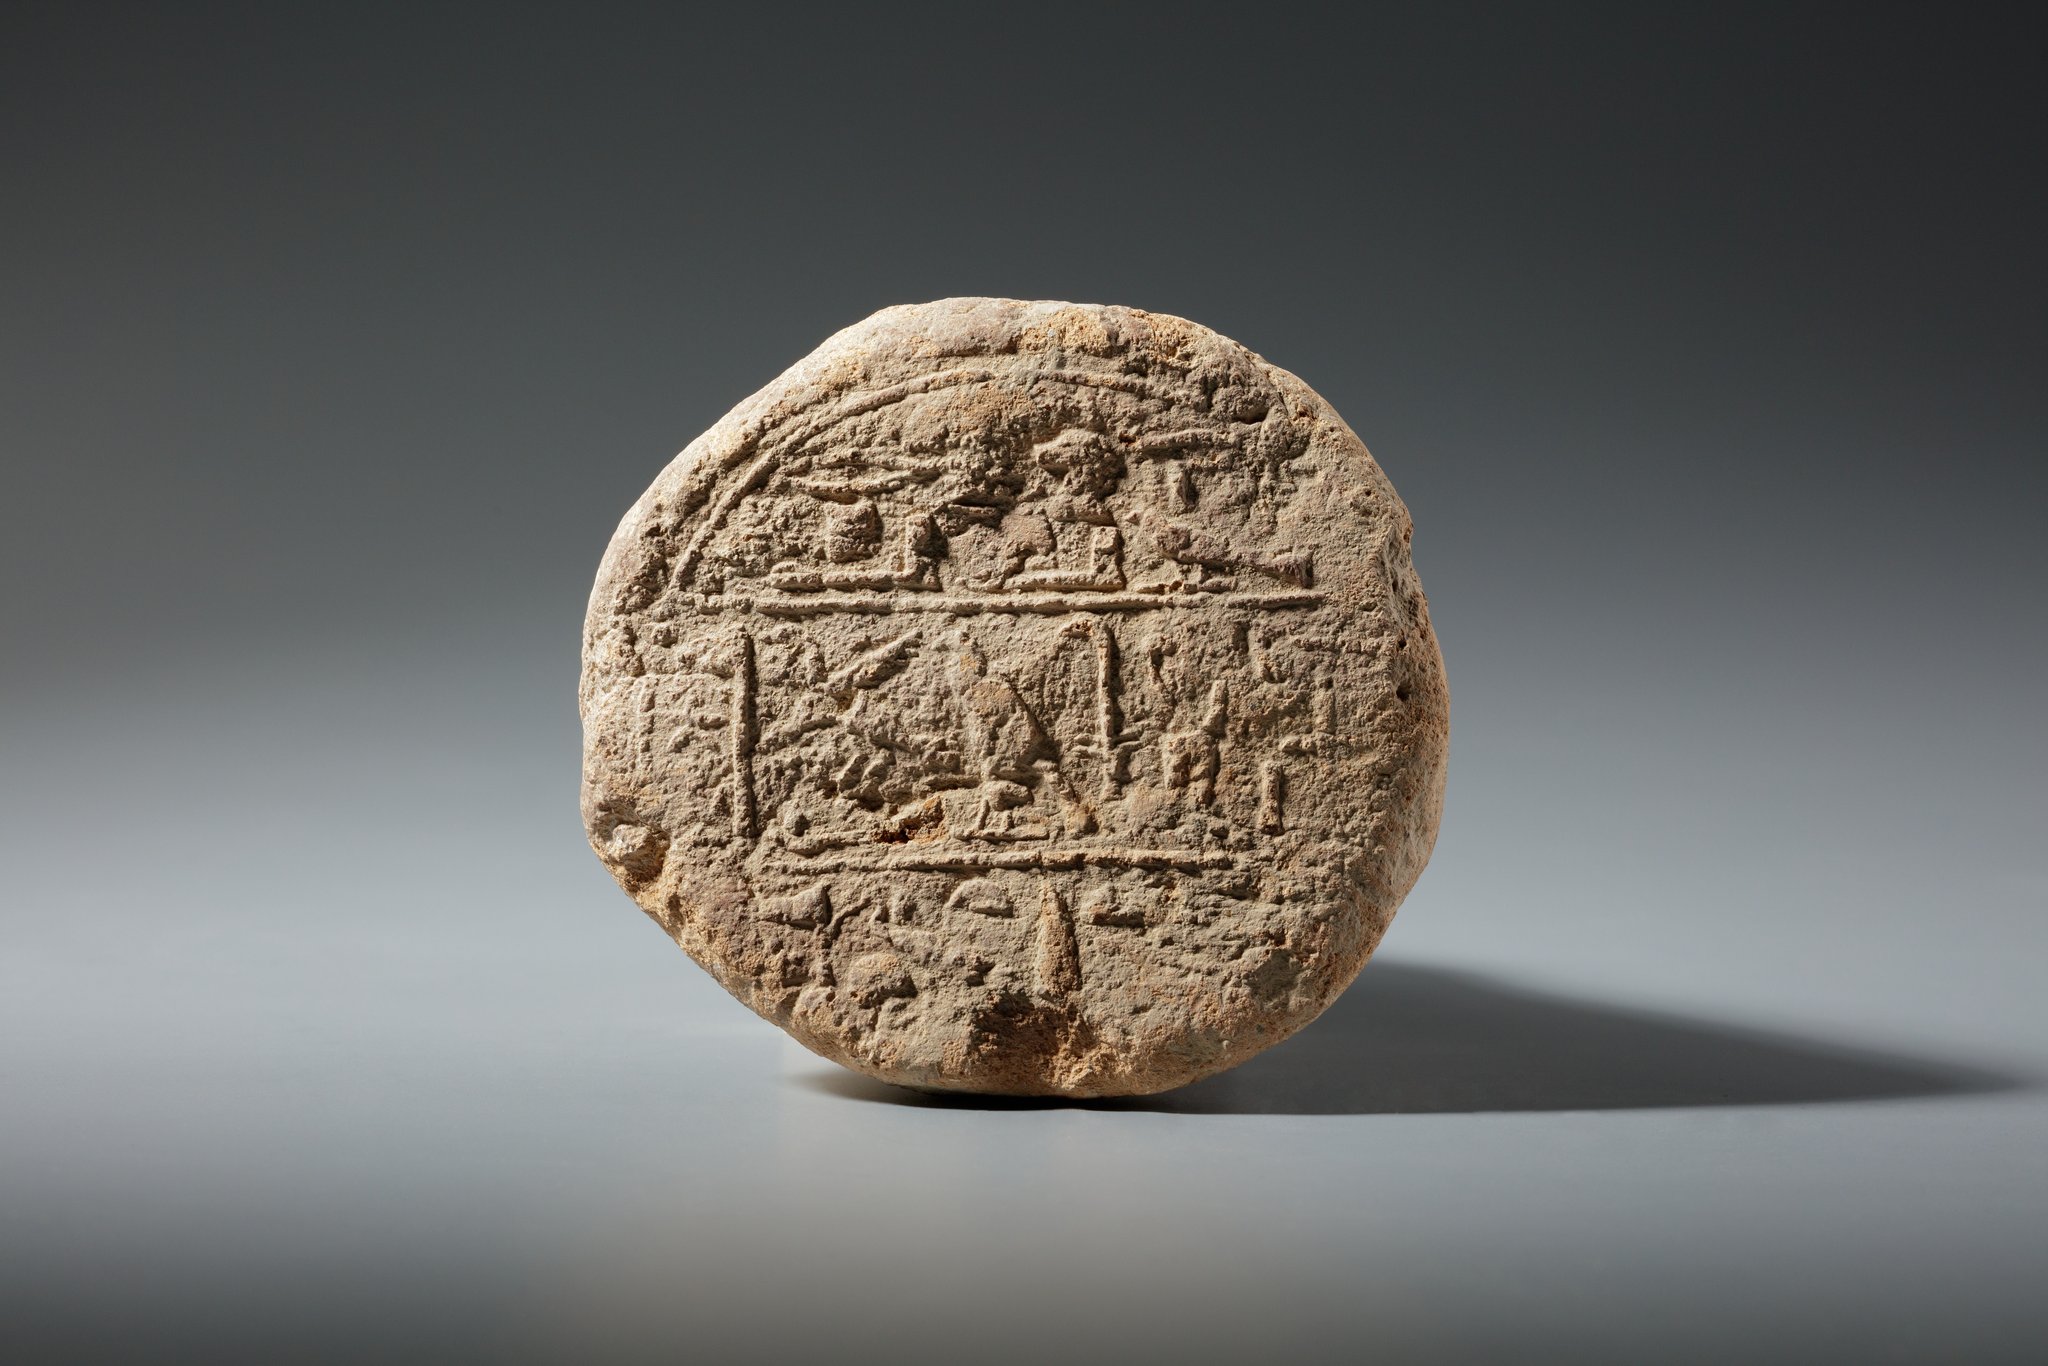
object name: cone, davy 515, padihorresnet, divine adoratress, adoratrice, akhetamenru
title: Funerary Cone of the Steward Padihorresnet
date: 688-525 BCE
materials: pottery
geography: egypt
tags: hieroglyphs